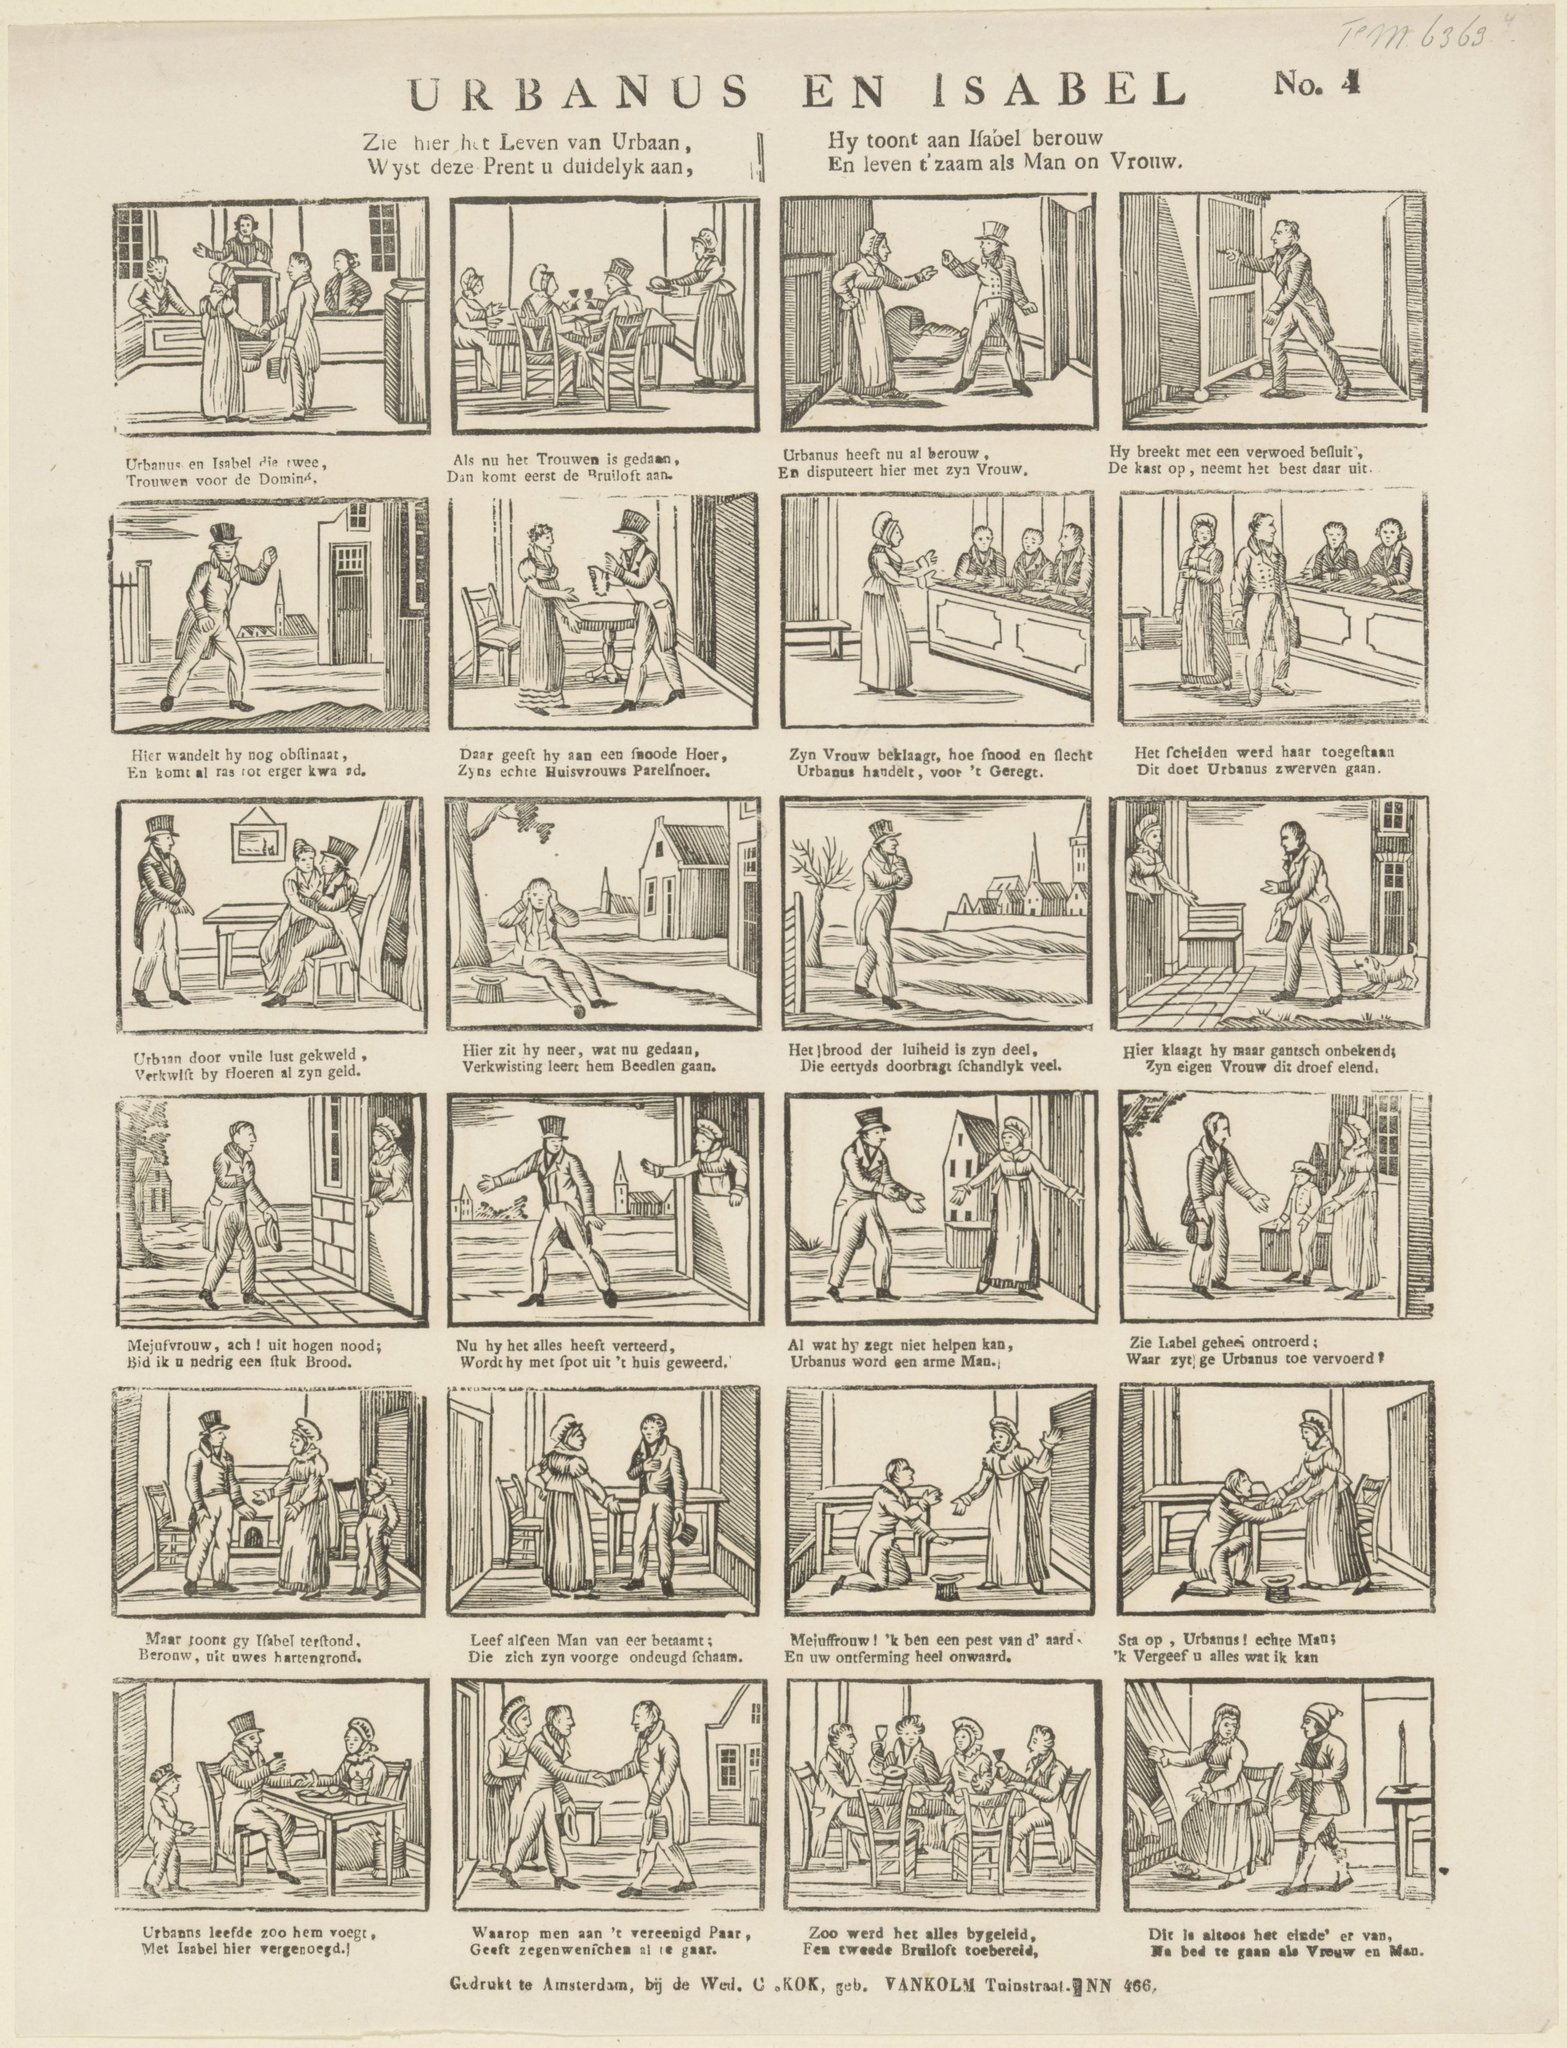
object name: print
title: Urbanus en Isabel / Zie hier het leven van Urbaan (...)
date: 1842-1866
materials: paper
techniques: letterpress printing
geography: netherlands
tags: divorce, beggar, man and wife quarrelling, 'marriage à la mode'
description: Blad met 24 voorstellingen uit het leven van Urbanus en Isabel. Ze trouwen, maken ruzie, gaan scheiden, en Urbanus wordt een bedelaar. Onder elke afbeelding een tweeregelig vers. Genummerd rechtsboven: No. 4.